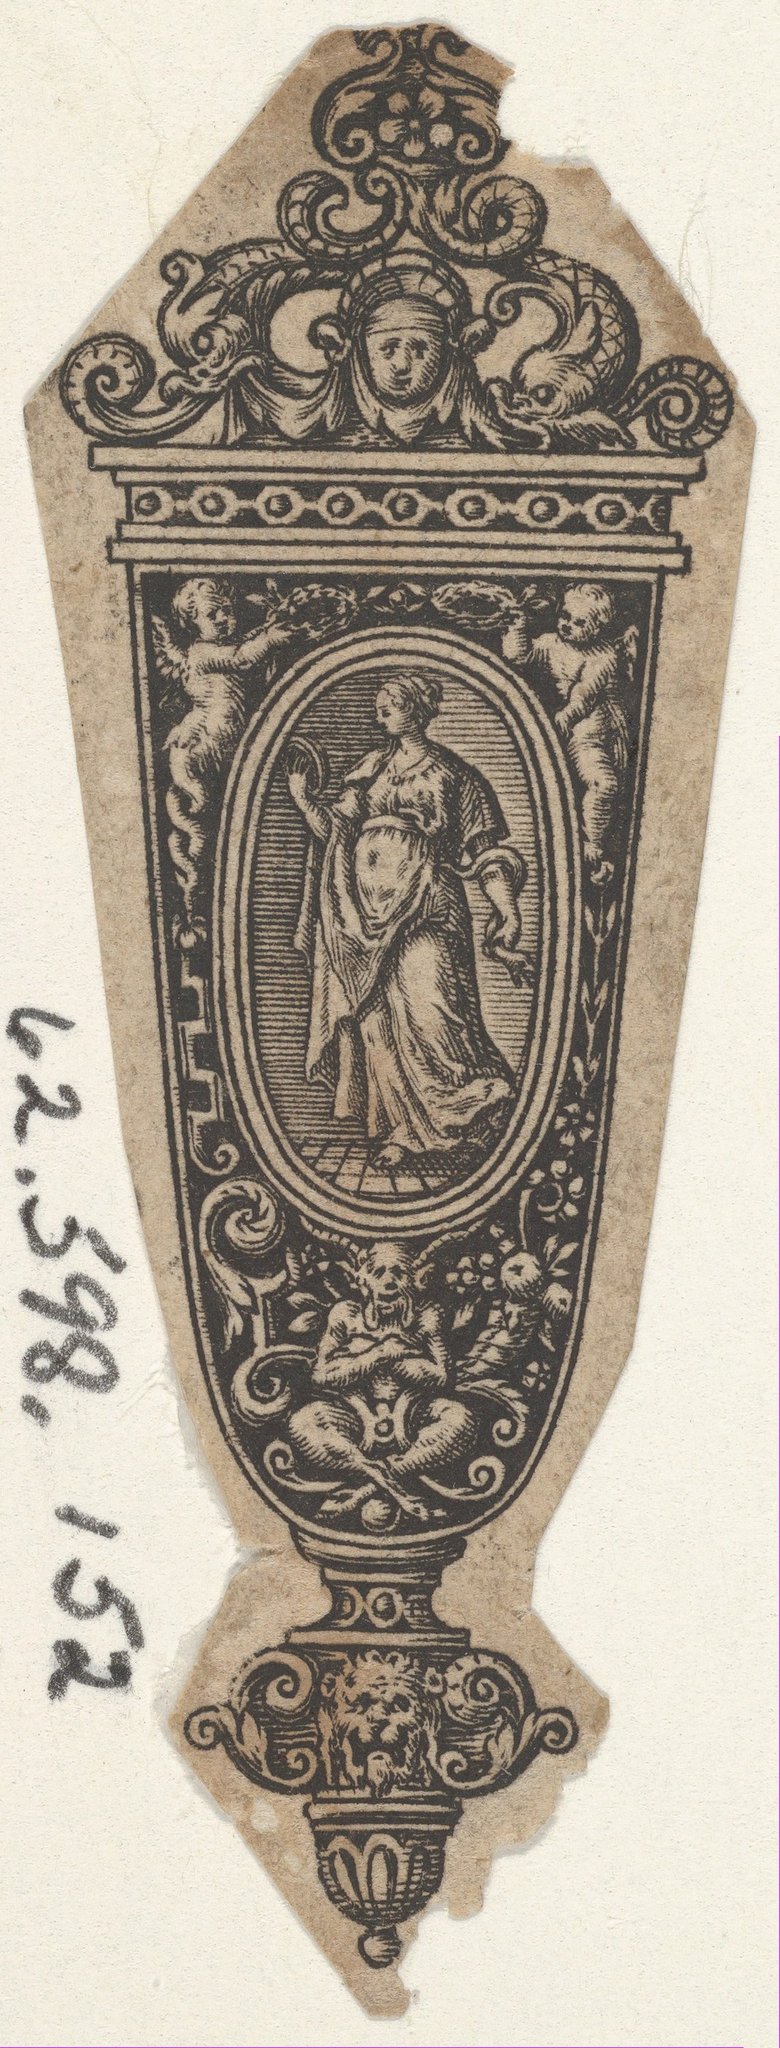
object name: print ornament architecture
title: Design for a Knife Handle (Fragment from Manches de Coutiaus)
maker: johann theodor de bry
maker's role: artist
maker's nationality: netherlandish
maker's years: 1561-1623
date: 1580-1600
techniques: embroidery, engraving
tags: hilts,faces,women